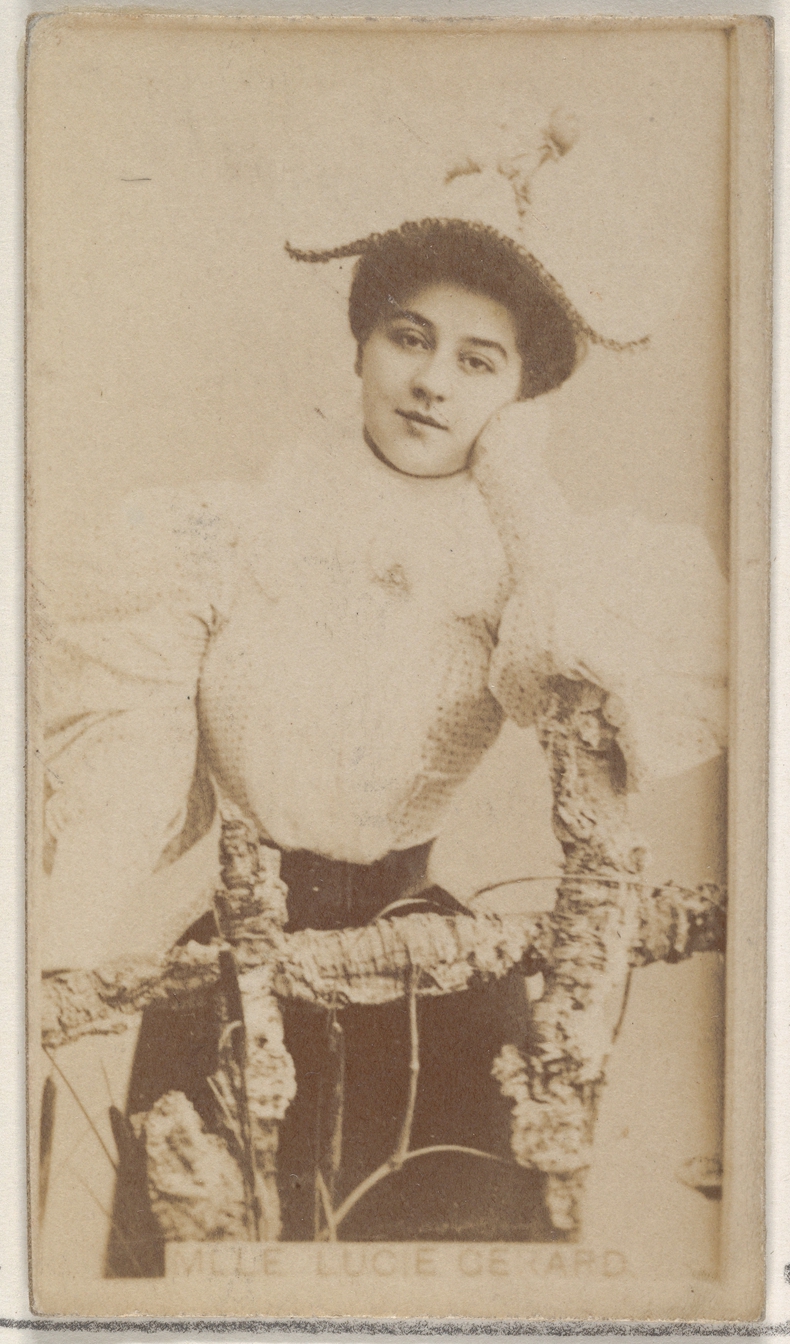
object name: photograph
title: Mlle. Lucie Gerard, from the Actors and Actresses series (N45, Type 8) for Virginia Brights Cigarettes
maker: allen & ginter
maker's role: publisher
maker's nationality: american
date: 1888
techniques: albumen silver print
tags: portraits,women,actresses